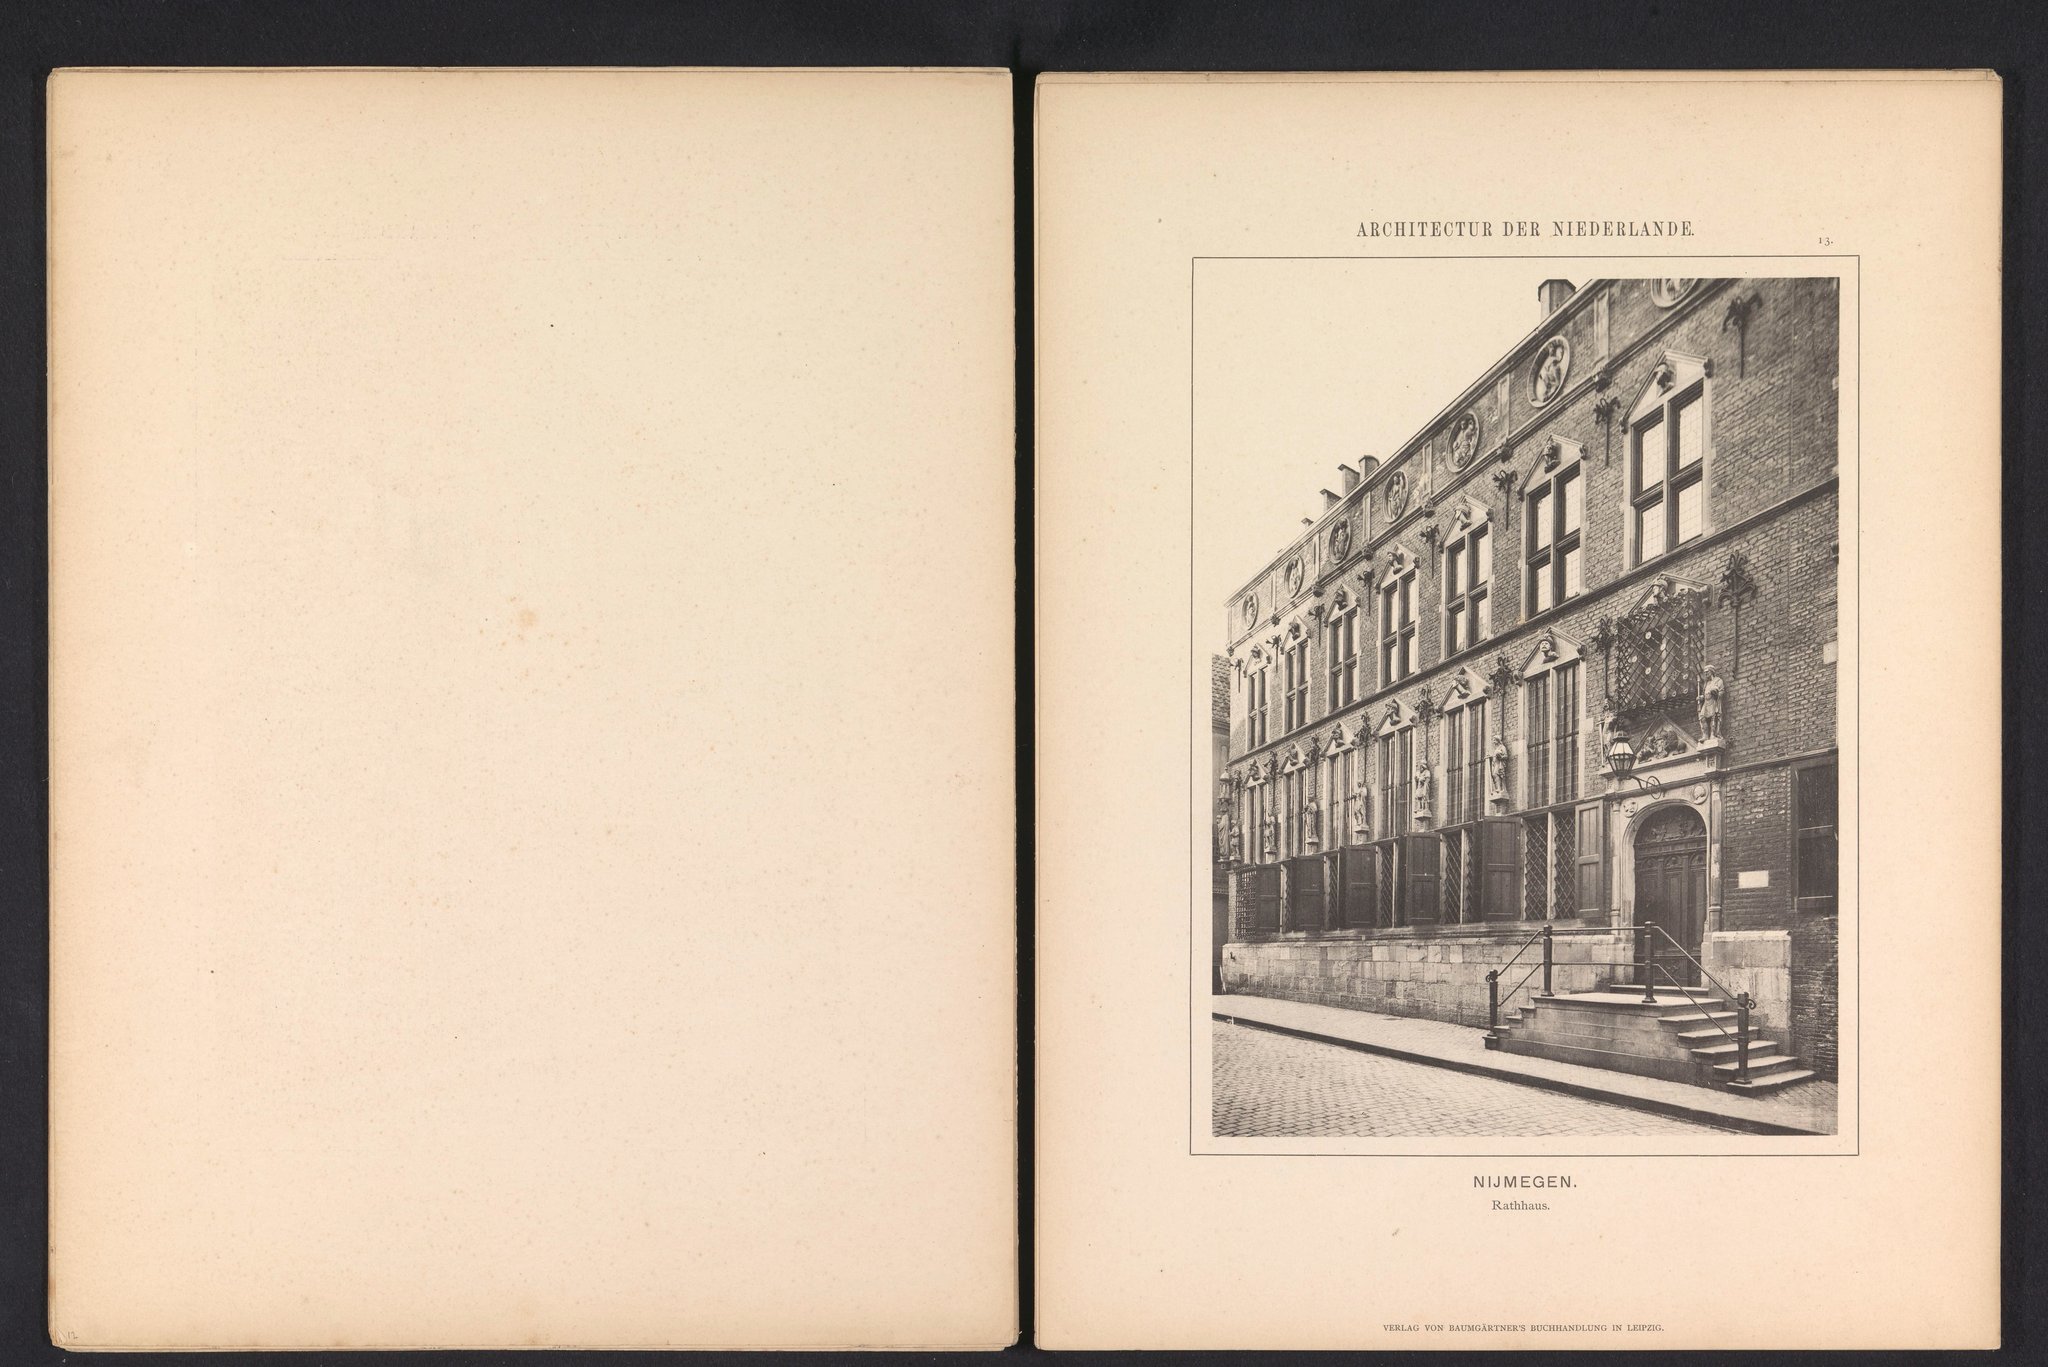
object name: page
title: Gezicht op het stadhuis van Nijmegen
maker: Anonymous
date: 1884-1894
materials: paper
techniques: photograph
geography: nijmegen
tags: townhall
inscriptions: number: ‘13.’